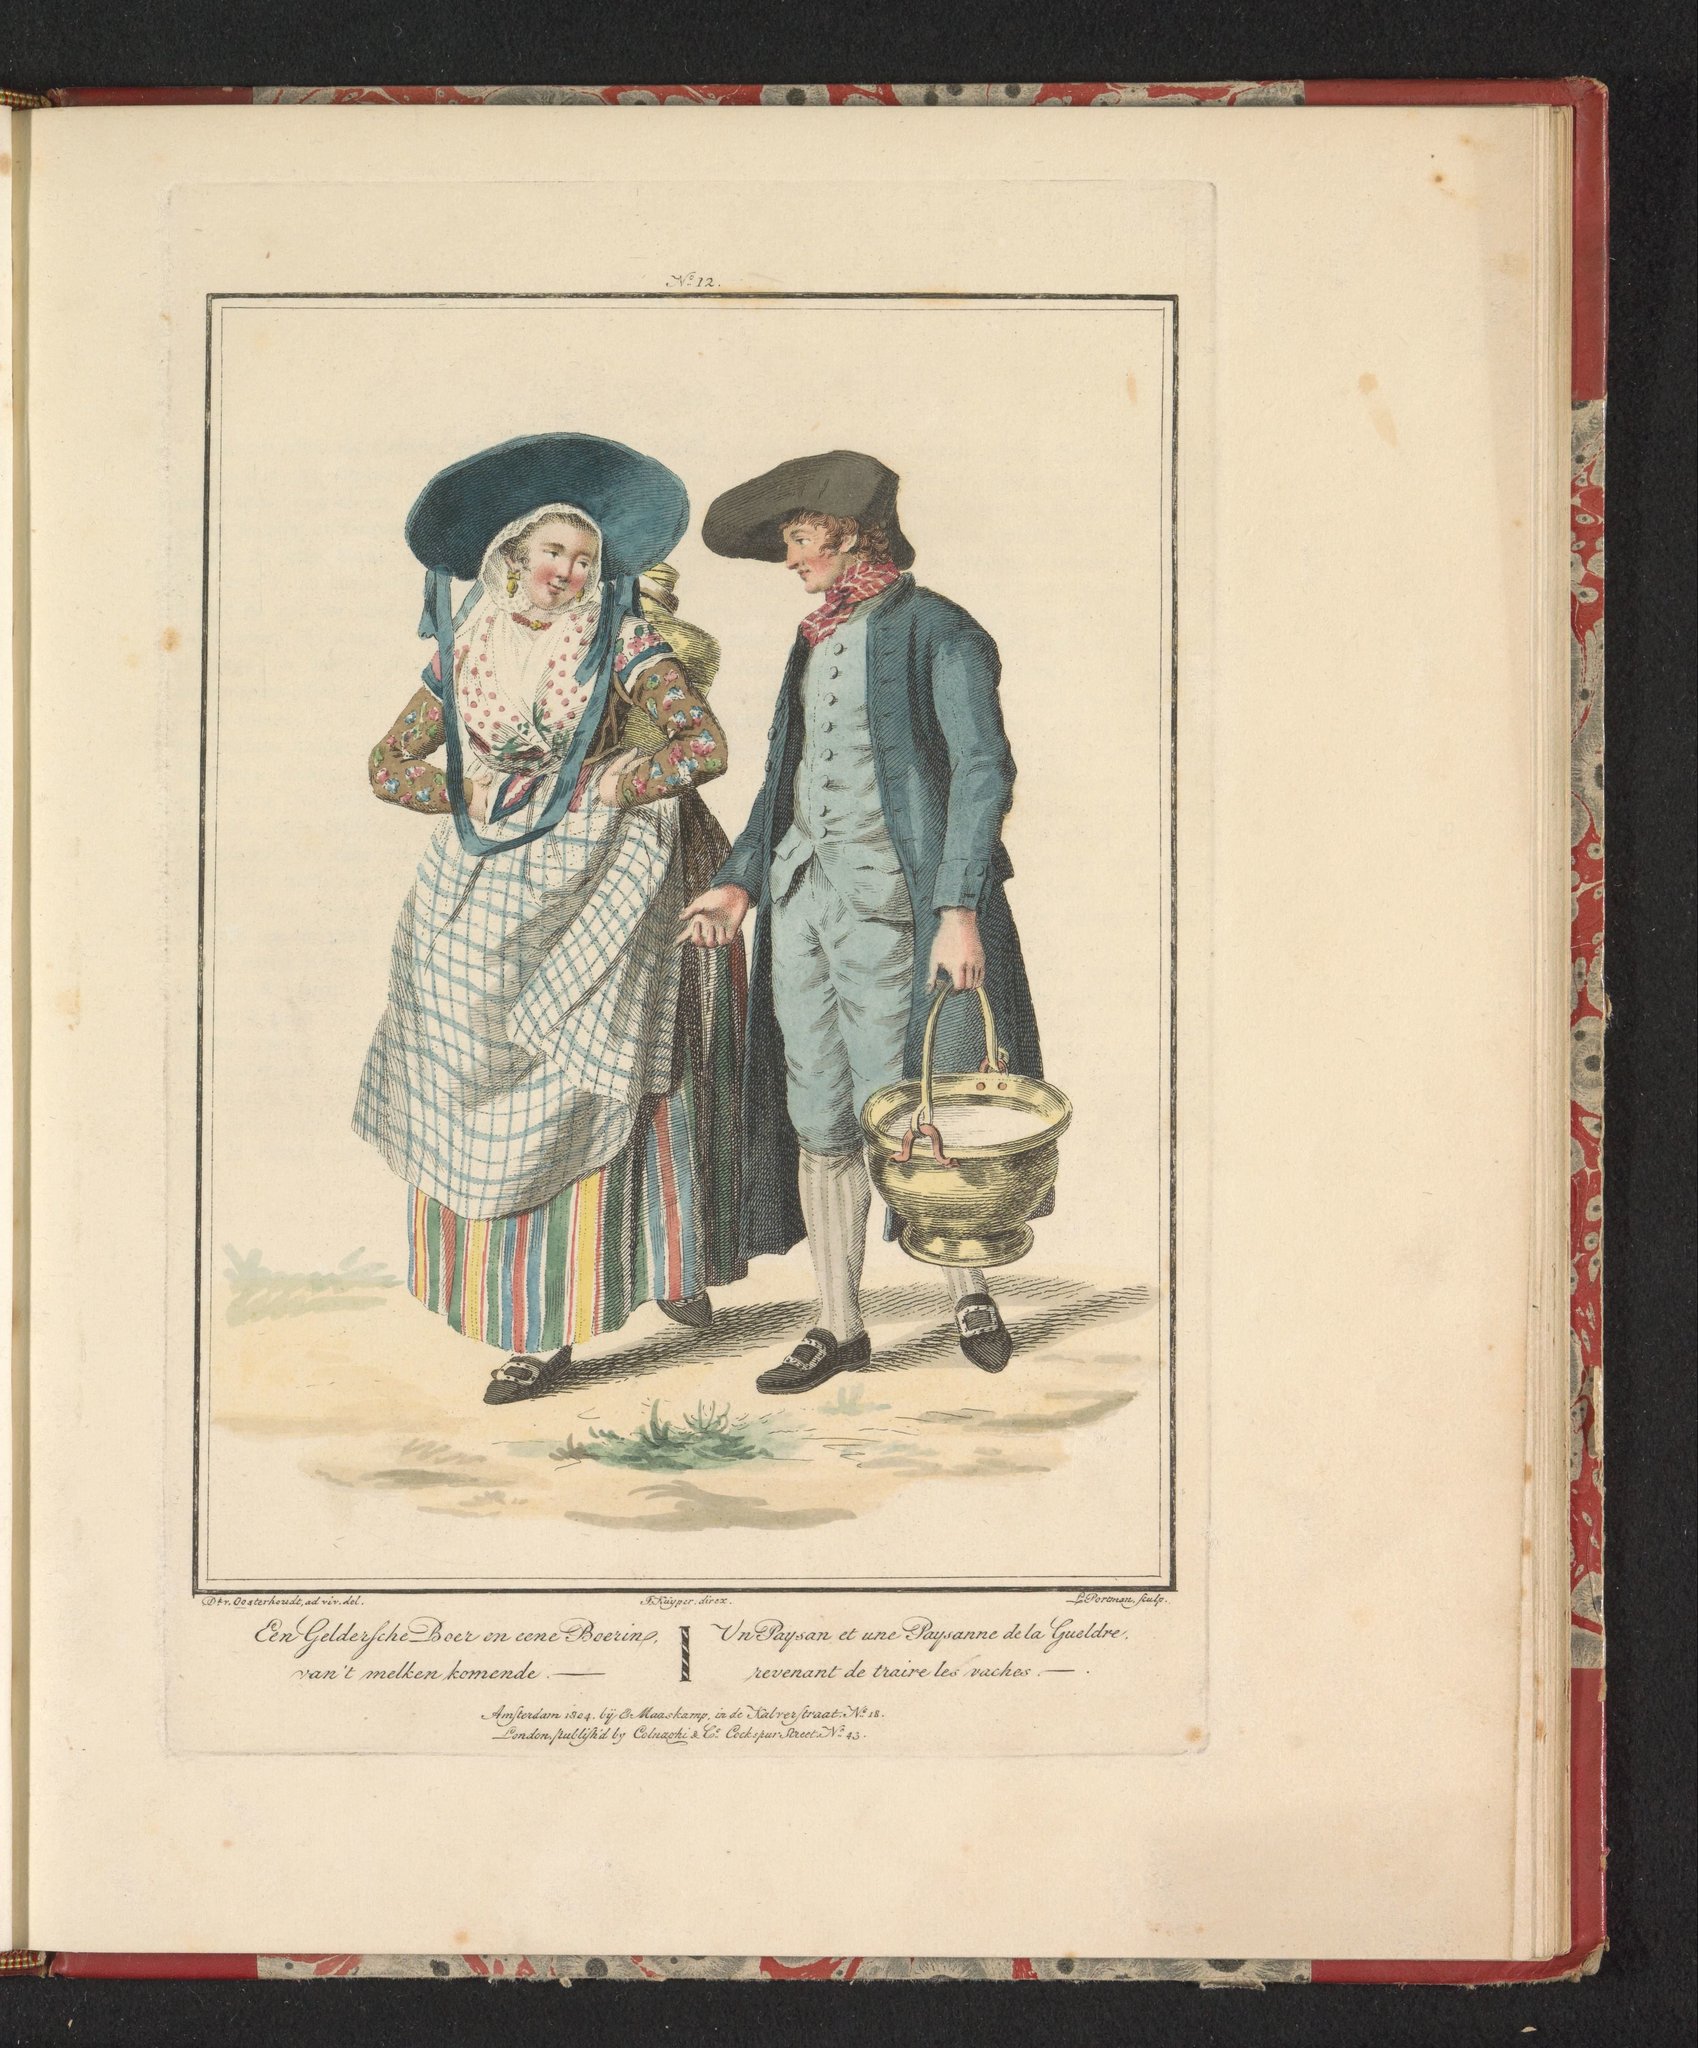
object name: print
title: Een Geldersche Boer en eene Boerin, van 't melken komende / Un Paysan et une Paysanne de la Gueldre, revenant de traire les vaches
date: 1804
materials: paper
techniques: etching, hand coloring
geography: gelderland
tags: folk costume, regional costume, milk, milkmaid, clothes, costume, gelderland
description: Een Gelders boerenpaar dat zojuist de koeien heeft gemolken. De boer draagt een vat met melk. Derde aflevering van vier platen, verschenen in 1804. Onderdeel van een gebonden uitgave van de reeks van twintig platen van Nederlandse klederdrachten in de Bataafse Republiek aan het begin van de negentiende eeuw door Maaskamp, ca. 1807.